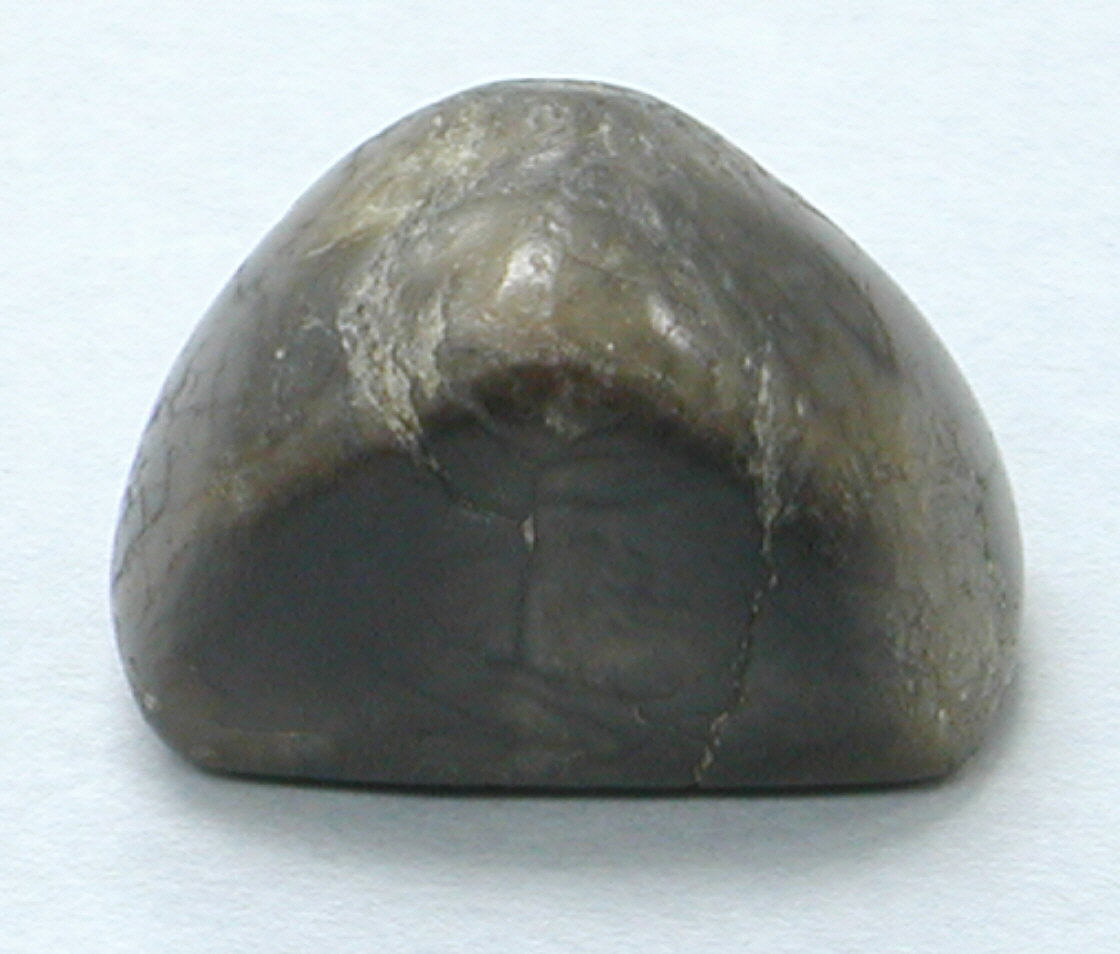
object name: ritual stone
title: Stone Pulidor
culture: mexican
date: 1501-1600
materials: stone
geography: mexico